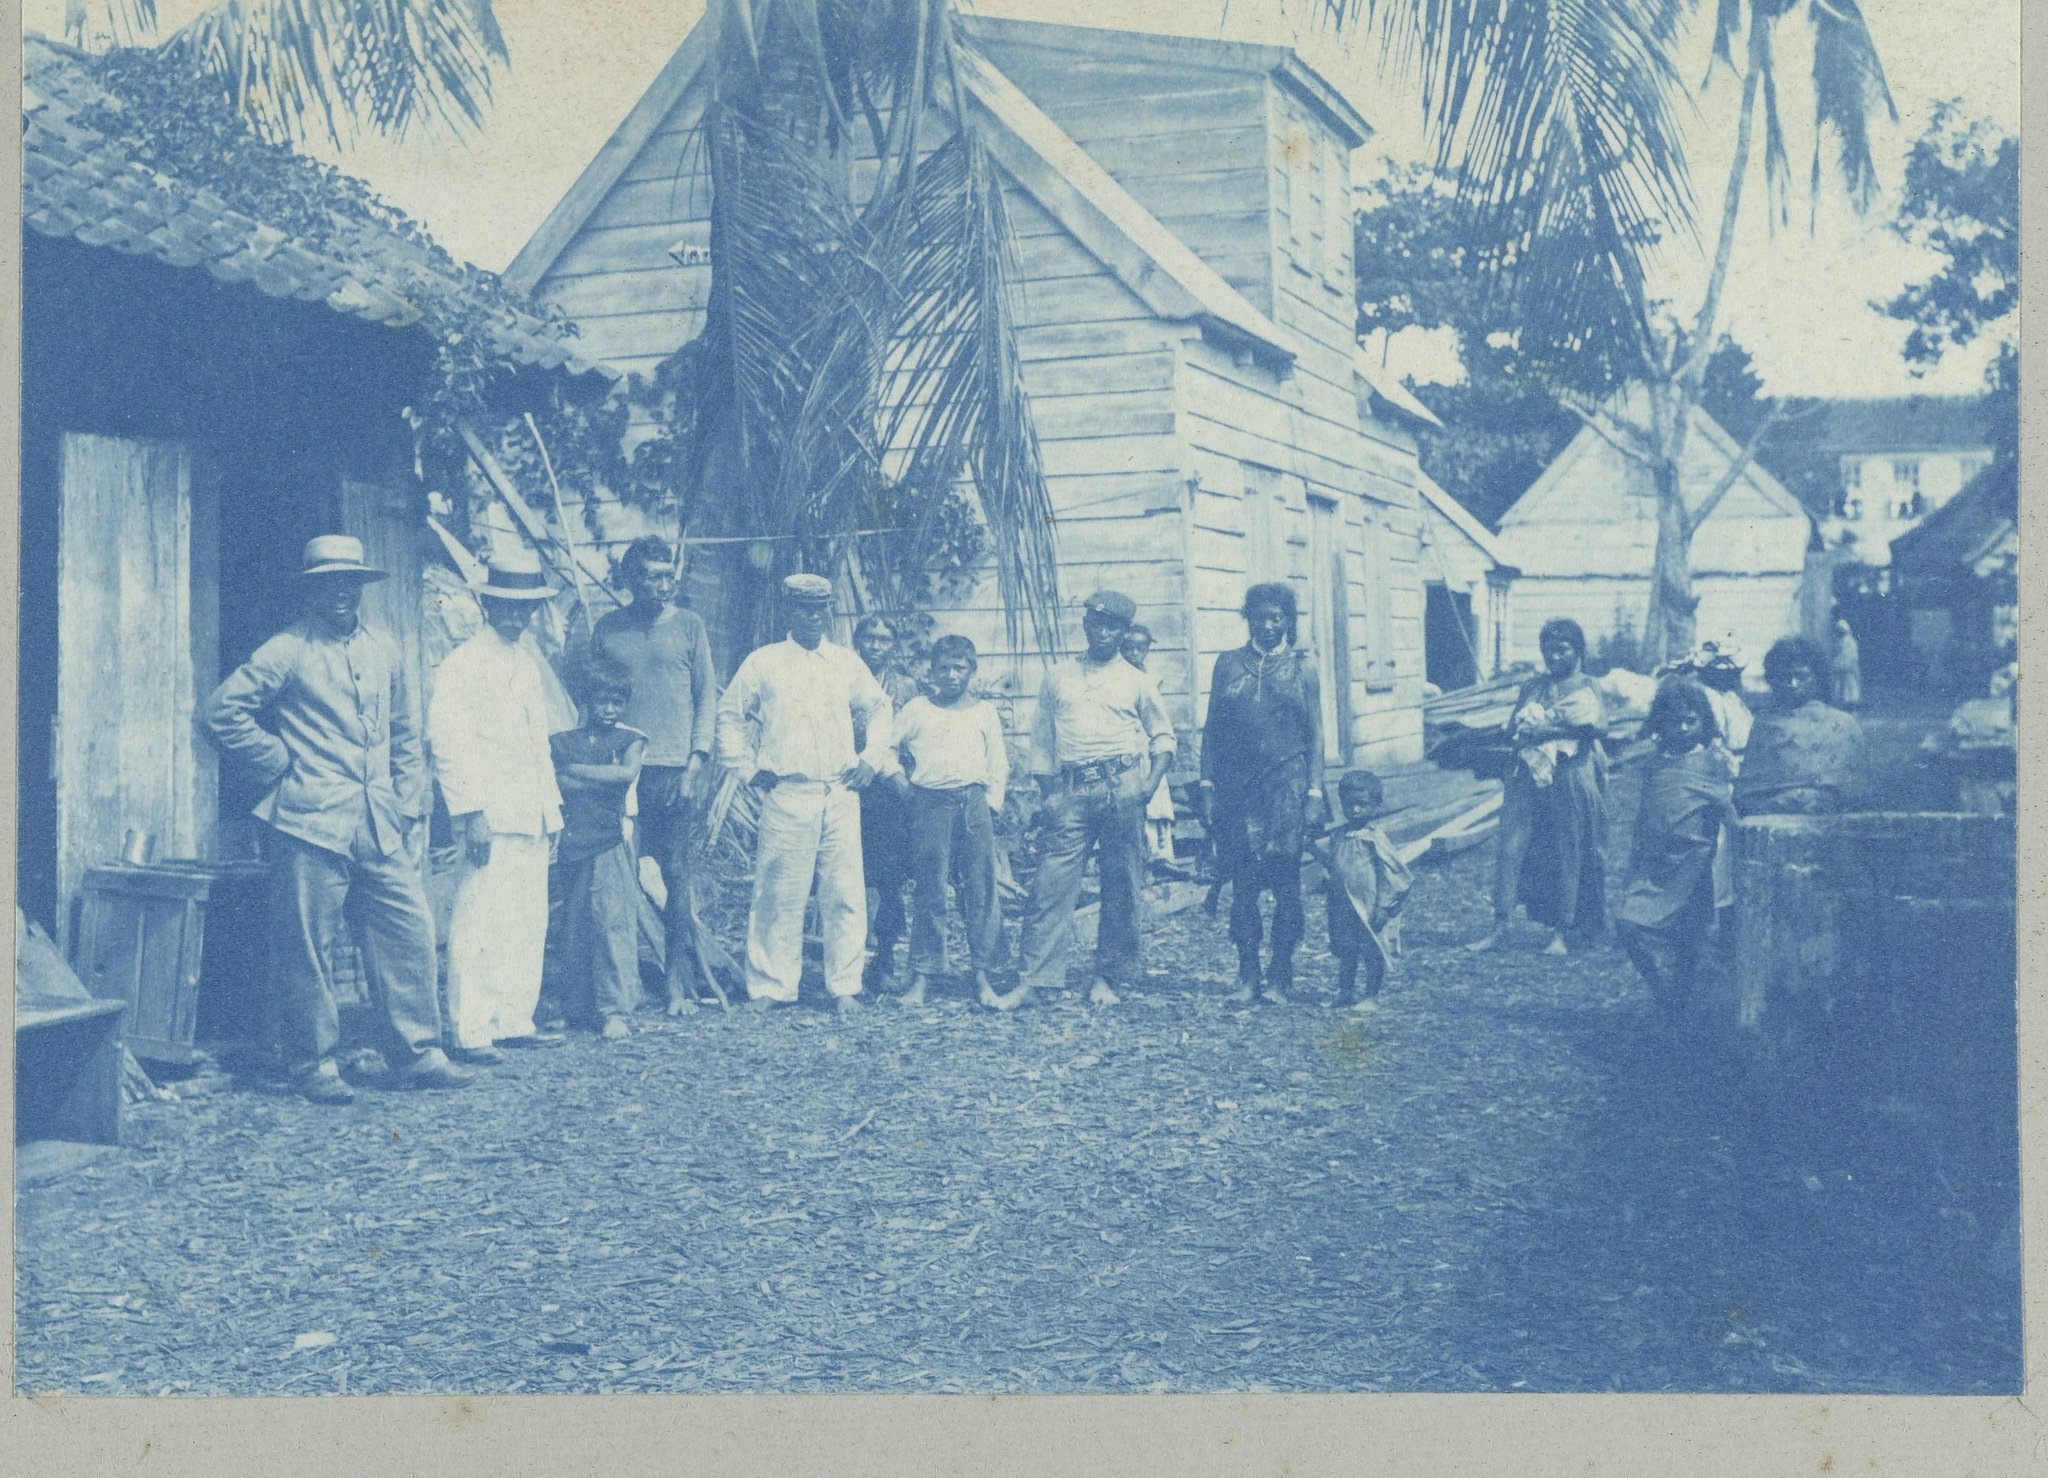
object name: photograph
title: Caräiben op erf in de Saramaccastraat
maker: hendrik doijer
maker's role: engineer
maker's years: 1863-1925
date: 1903-1910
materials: photographic support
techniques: cyanotype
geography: suriname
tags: indigenous peoples of south america, suriname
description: Gezicht op de Saramaccastraat te Paramaribo, met een groepje poserende Surinaamse Caraïben. Wanneer Caraïben naar Paramaribo kwamen, verbleven zij vaak in de Sarammacastraat, dichtbij de Surinamerivier waarover zij aankwamen. Onderdeel van het fotoalbum van de familie Doijer, Souvenir de Voyage (deel 1), in en rond de plantage Ma Retraite in Suriname in de jaren 1903-1910.